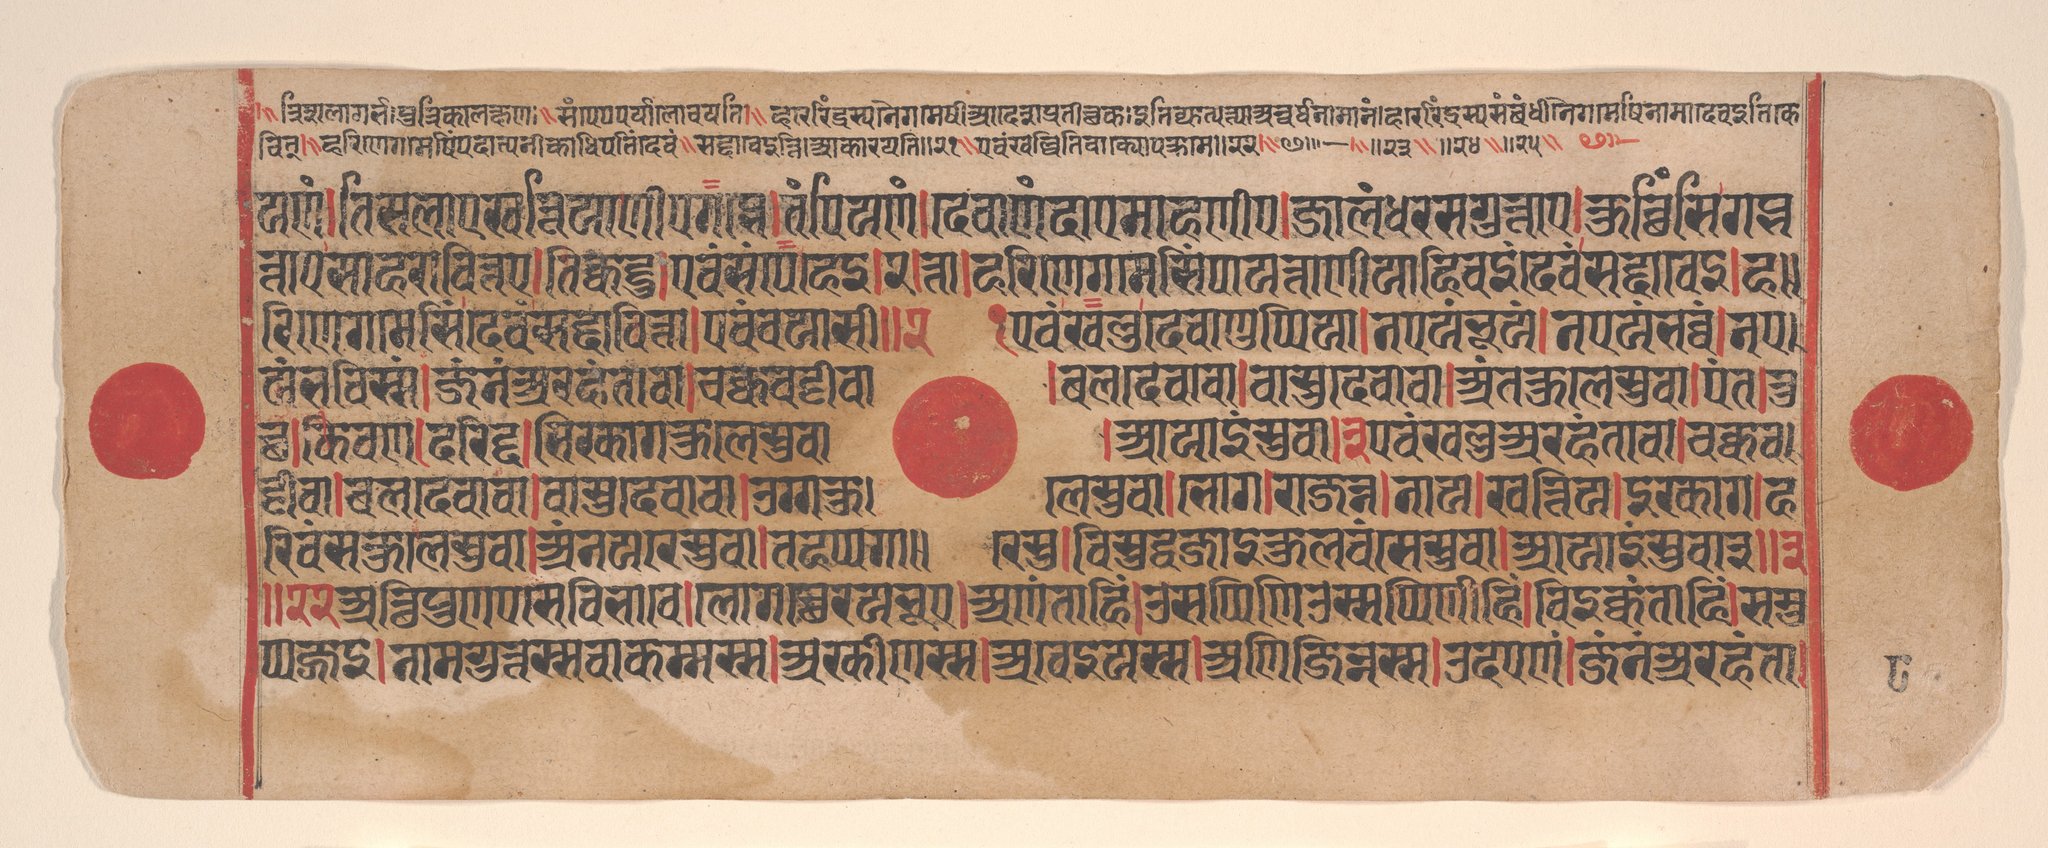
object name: folio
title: Leaf from a Kalpa Sutra (Jain Book of Rituals)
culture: indian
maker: bhadrabahu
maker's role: artist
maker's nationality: indian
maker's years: 356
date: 1401-1500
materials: gold, ink, paper, watercolor